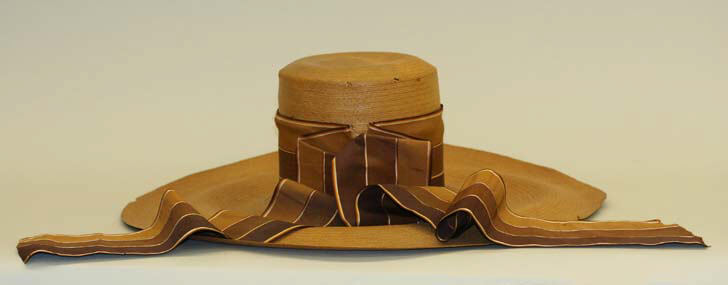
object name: hat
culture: american or european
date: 1830-1839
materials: fiber